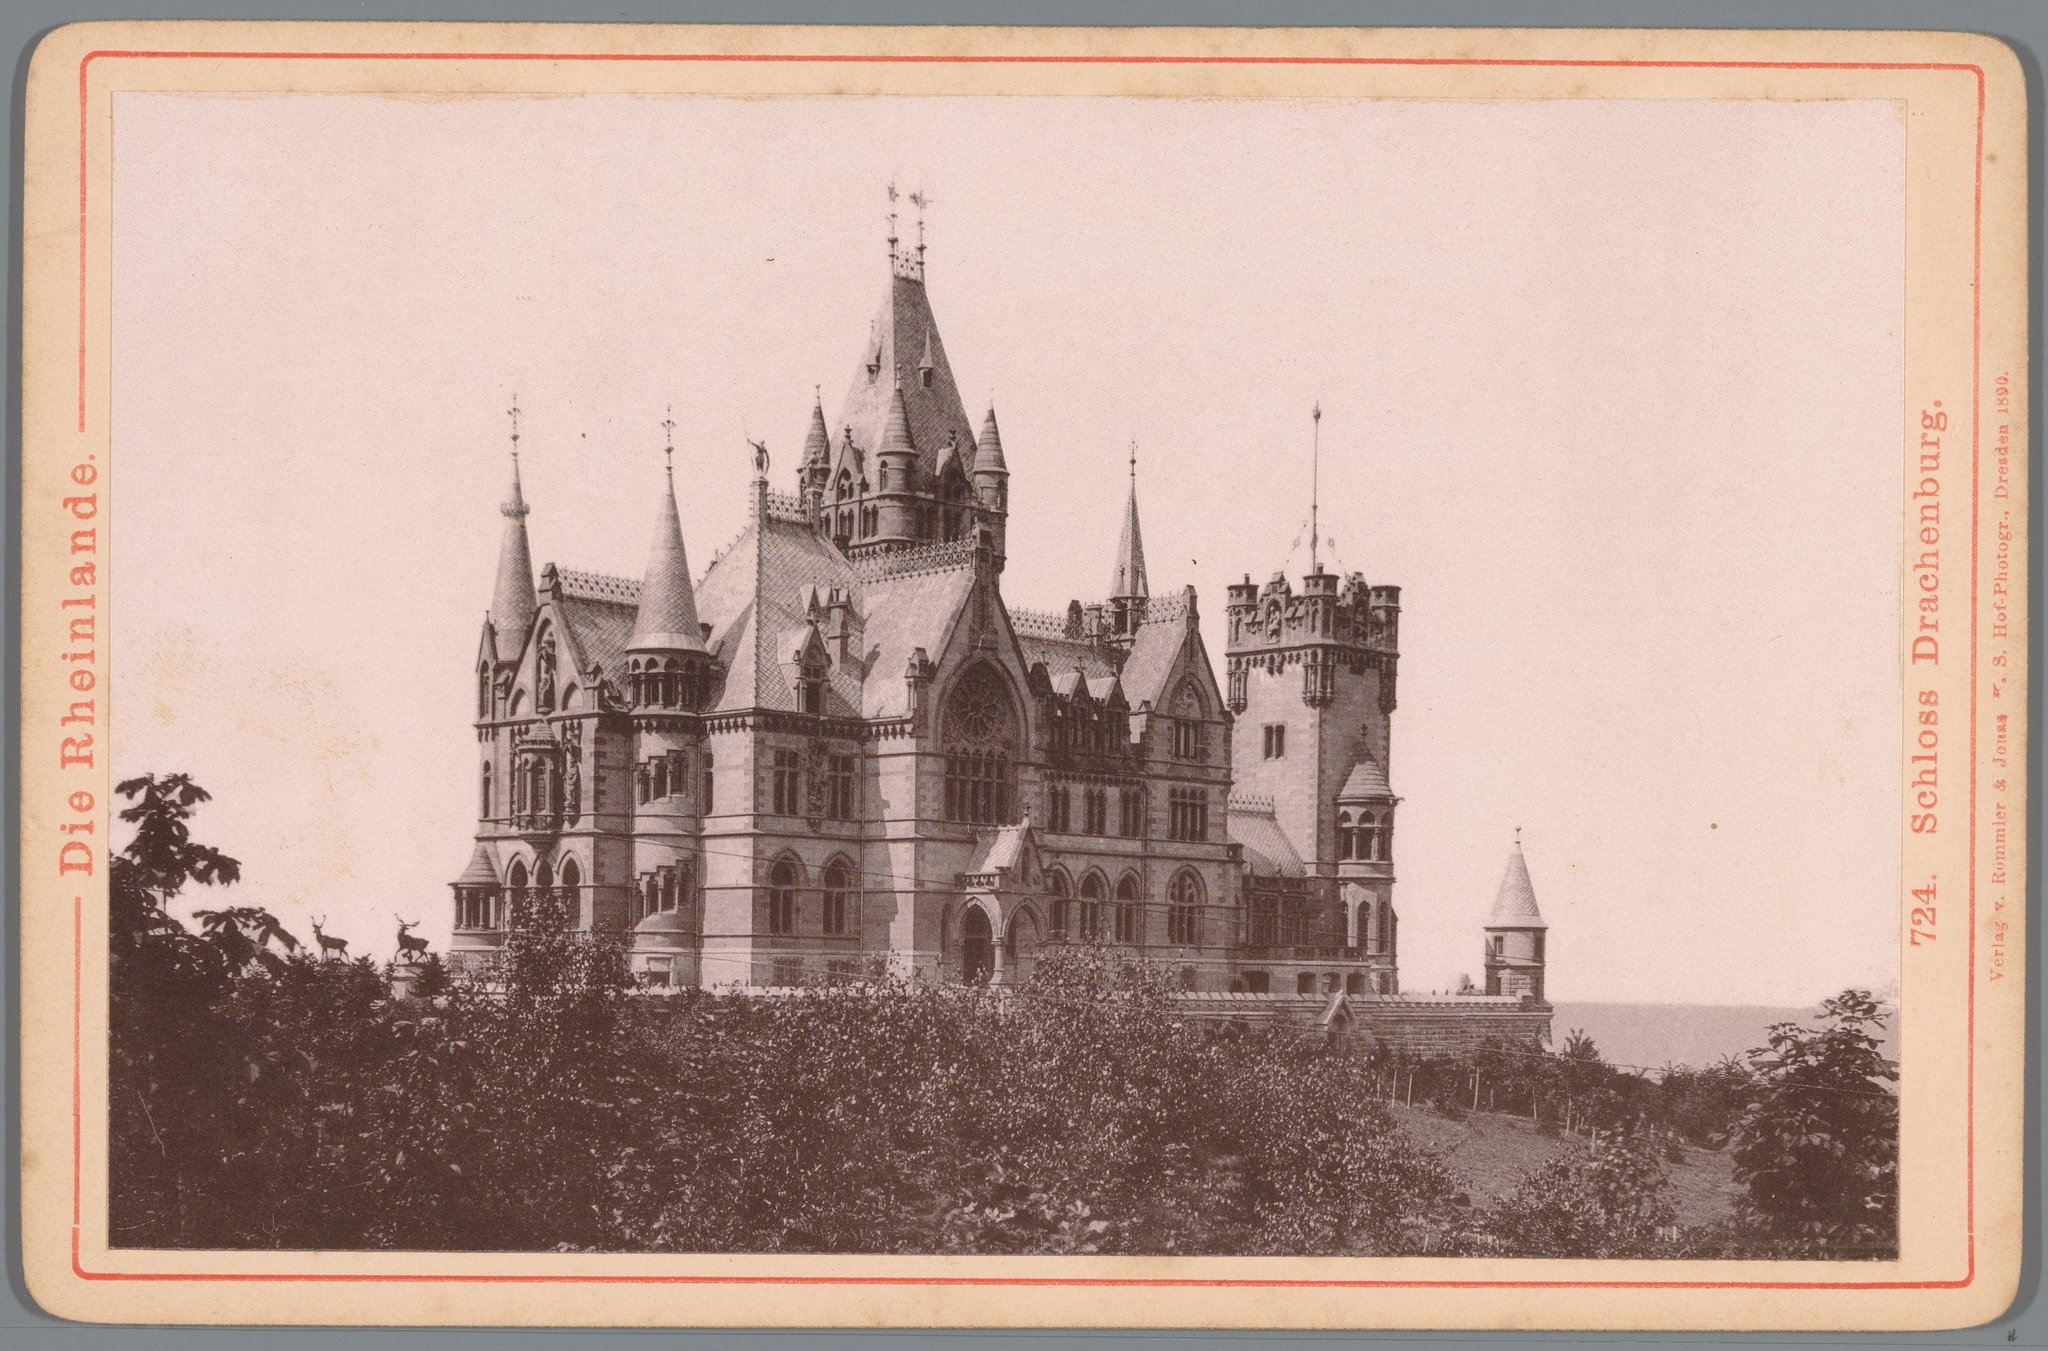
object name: cabinet photograph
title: Gezicht op het slot Drachenburg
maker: Anonymous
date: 1890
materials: cardboard, paper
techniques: photograph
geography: dresden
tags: castle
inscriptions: name: ‘Vosmaer’, name: ‘Ausgabe Römmler & Jonas In gleicher Ausgabe sind einzeln und im Album erschienen: Aachen Arth-Rigibahn (...)’, number: ‘724.’